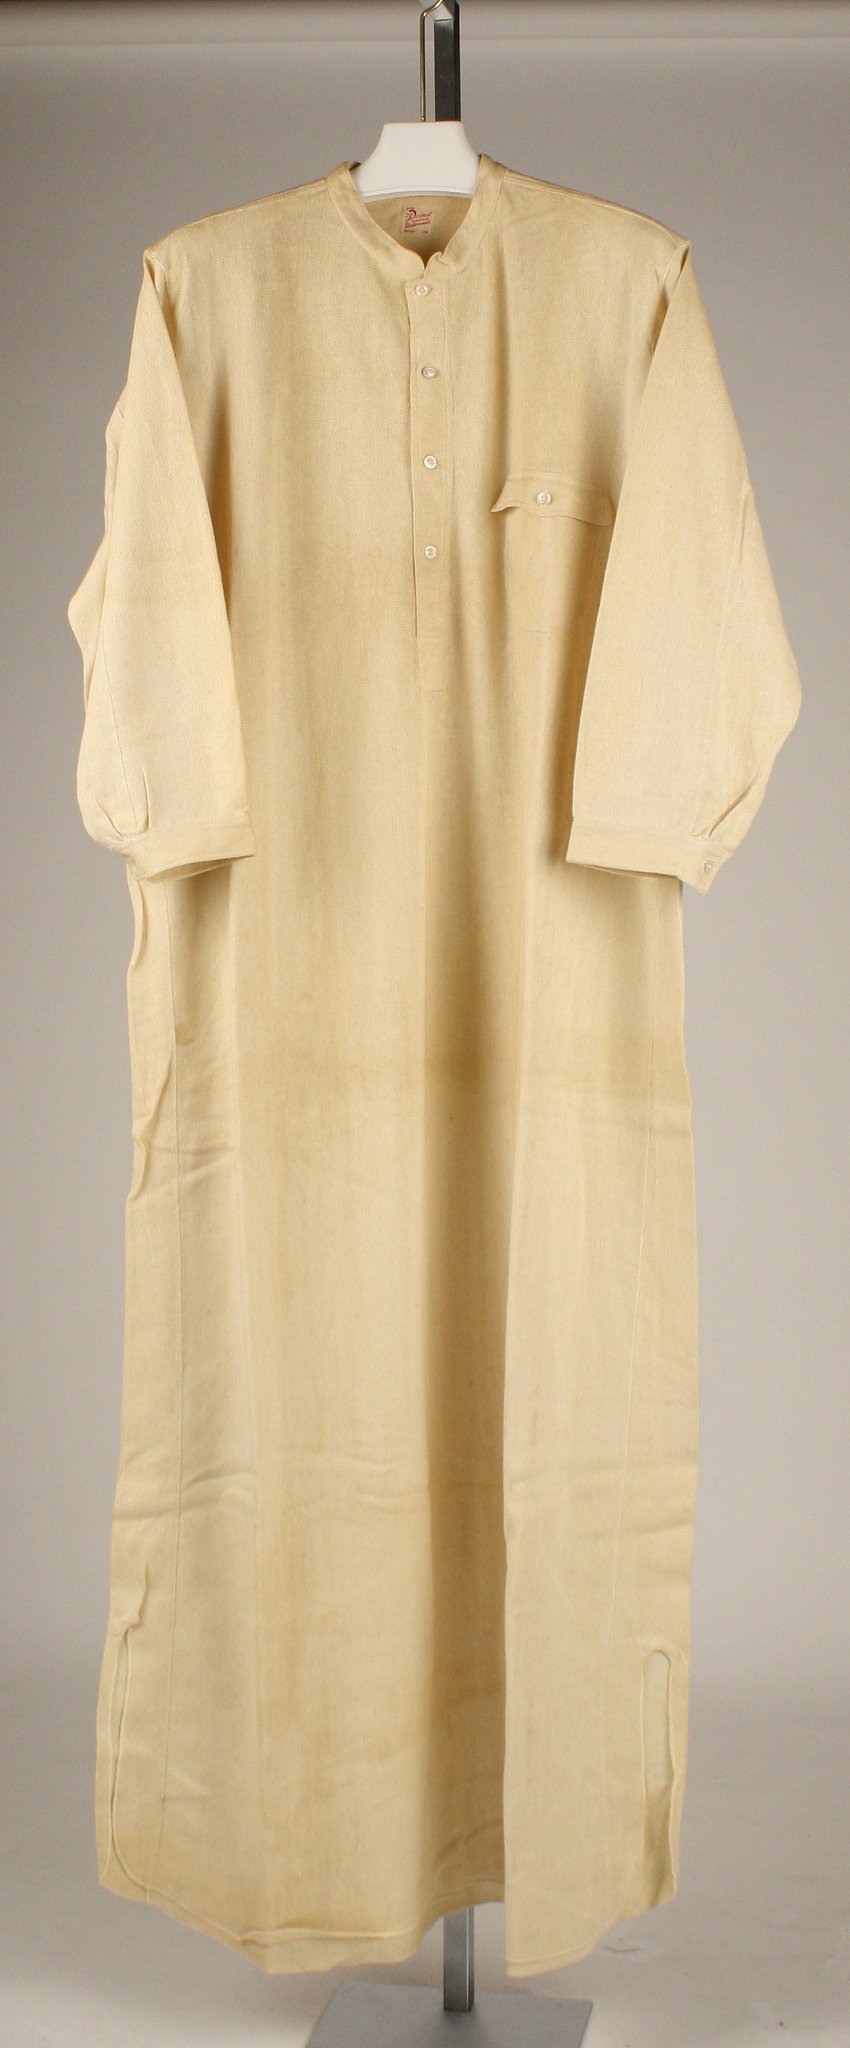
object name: nightshirt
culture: american or european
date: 1850-1915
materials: linen